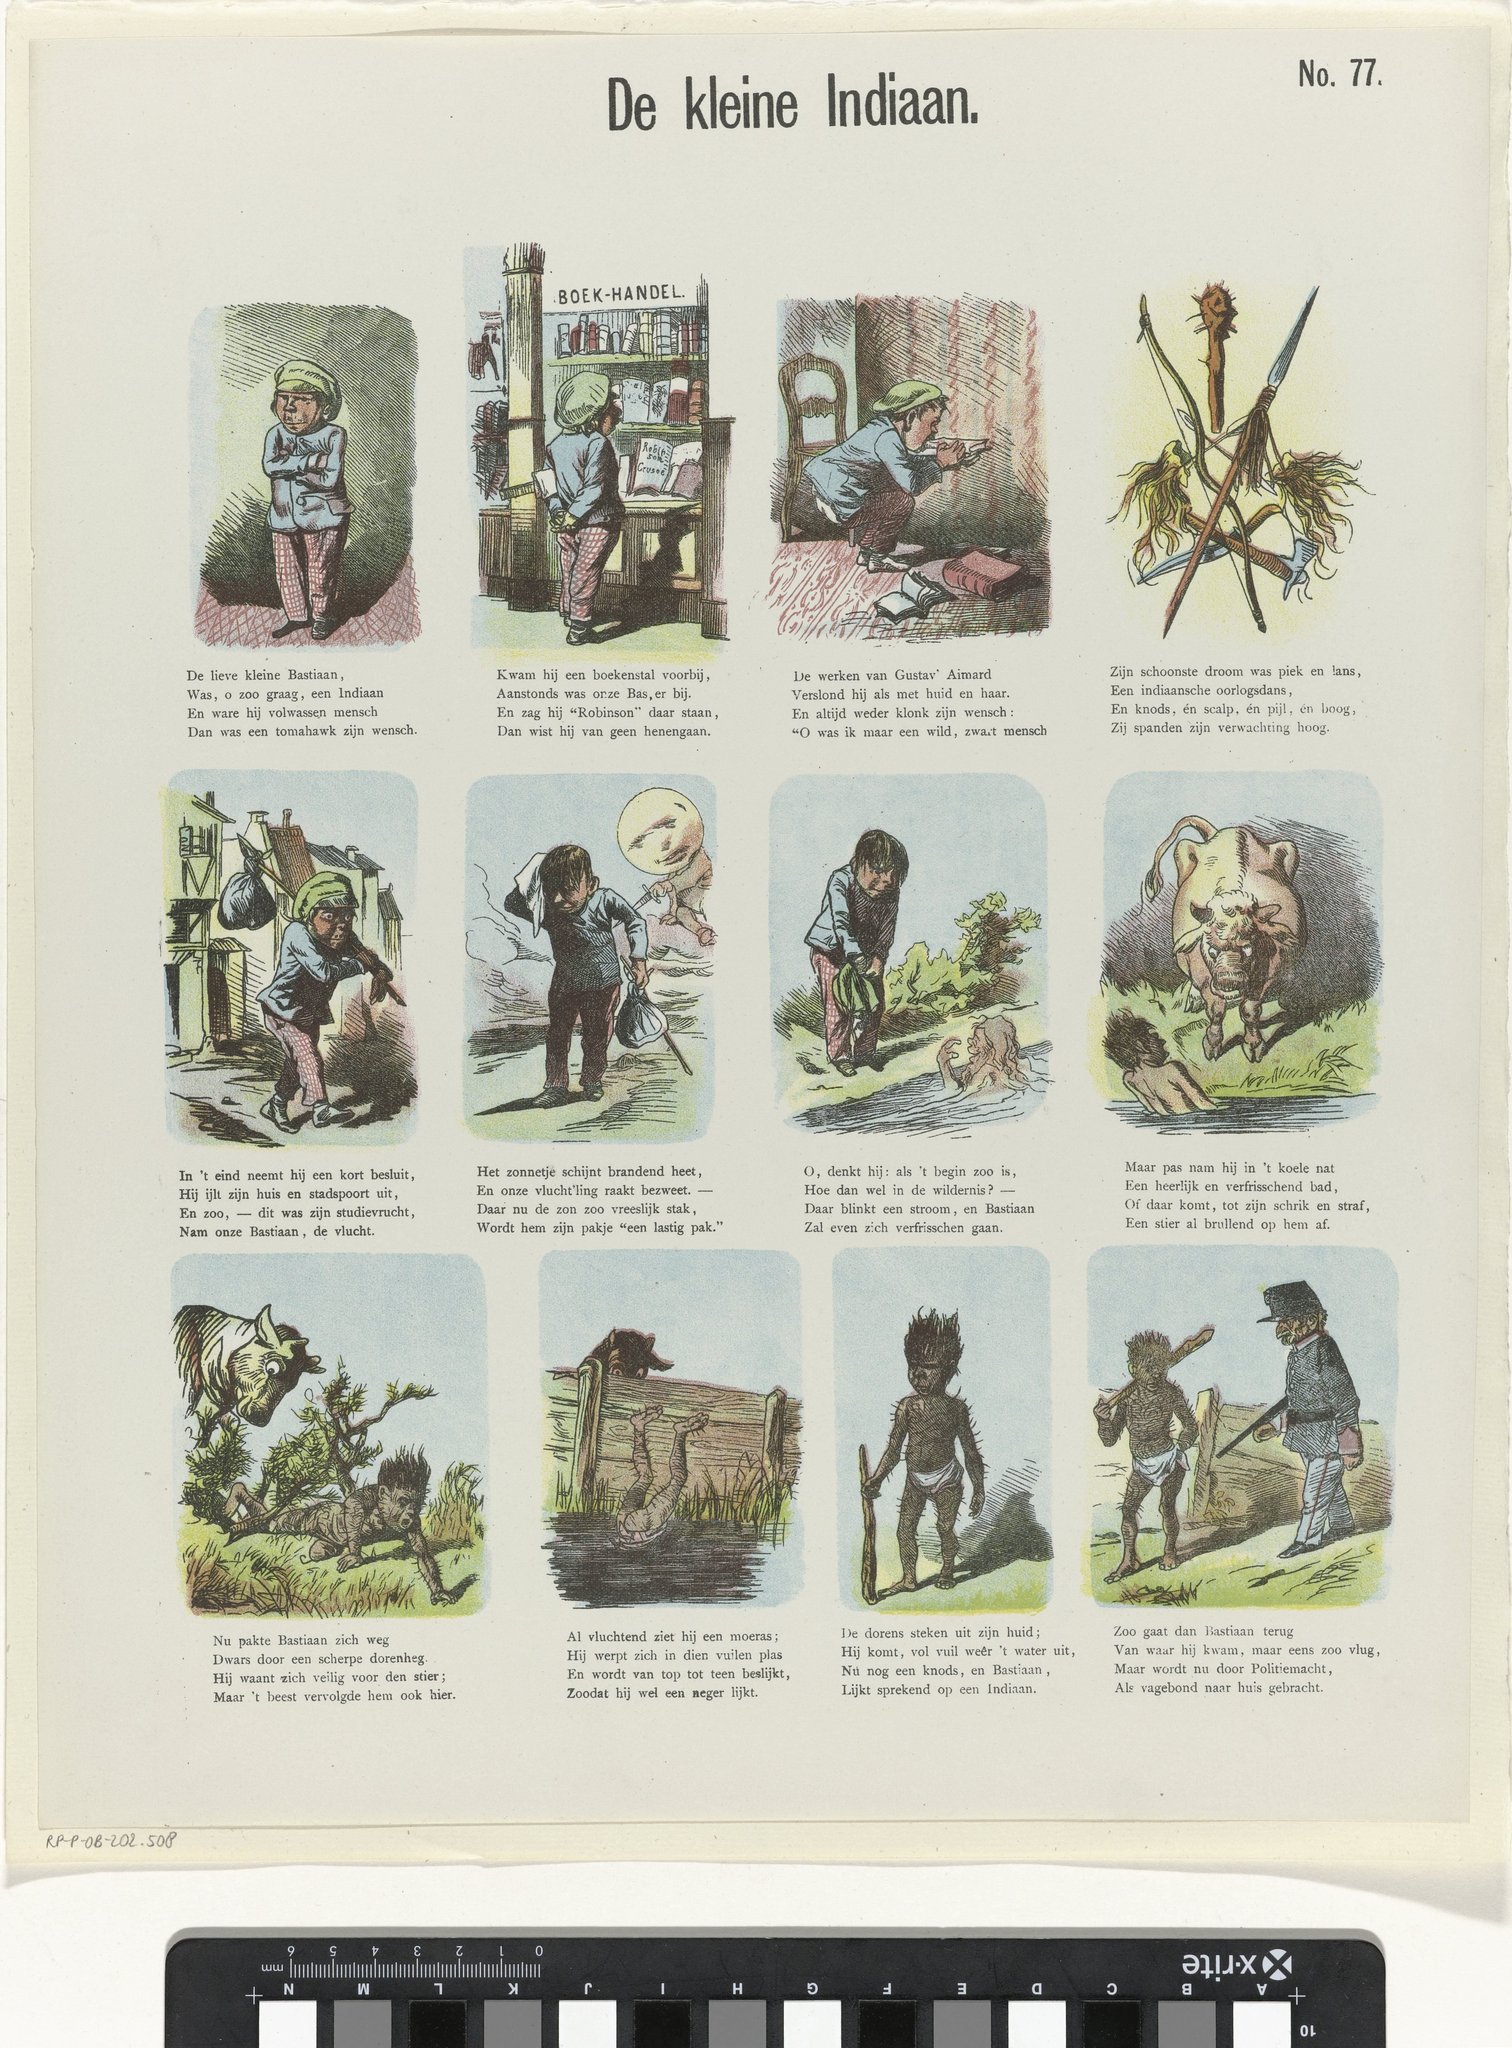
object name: popular print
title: Beeldverhaal getiteld ‘De kleine Indiaan’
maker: Anonymous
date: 1881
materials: paper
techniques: lithograph, letterpress printing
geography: amsterdam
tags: child, indigenous peoples of north america (+ caricatured), swamps and polders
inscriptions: collector's mark: Lugt 2760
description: Blad met twaalf voorstellingen over de kleine Bastiaan die graag een 'indiaan' wil zijn. Hij gaat afkoelen in een stroom, maar wordt door een stier in een prikkelstruik gejaagd en in een moeras. Door alle ongelukken ziet Bastiaan er aan het eind zo verwilderd uit dat hij volgens het verhaal sprekend op een 'indiaan' lijkt en door een agent naar huis wordt gebracht. Onder elke afbeelding een vierregelig vers. Genummerd rechtsboven: No. 77.